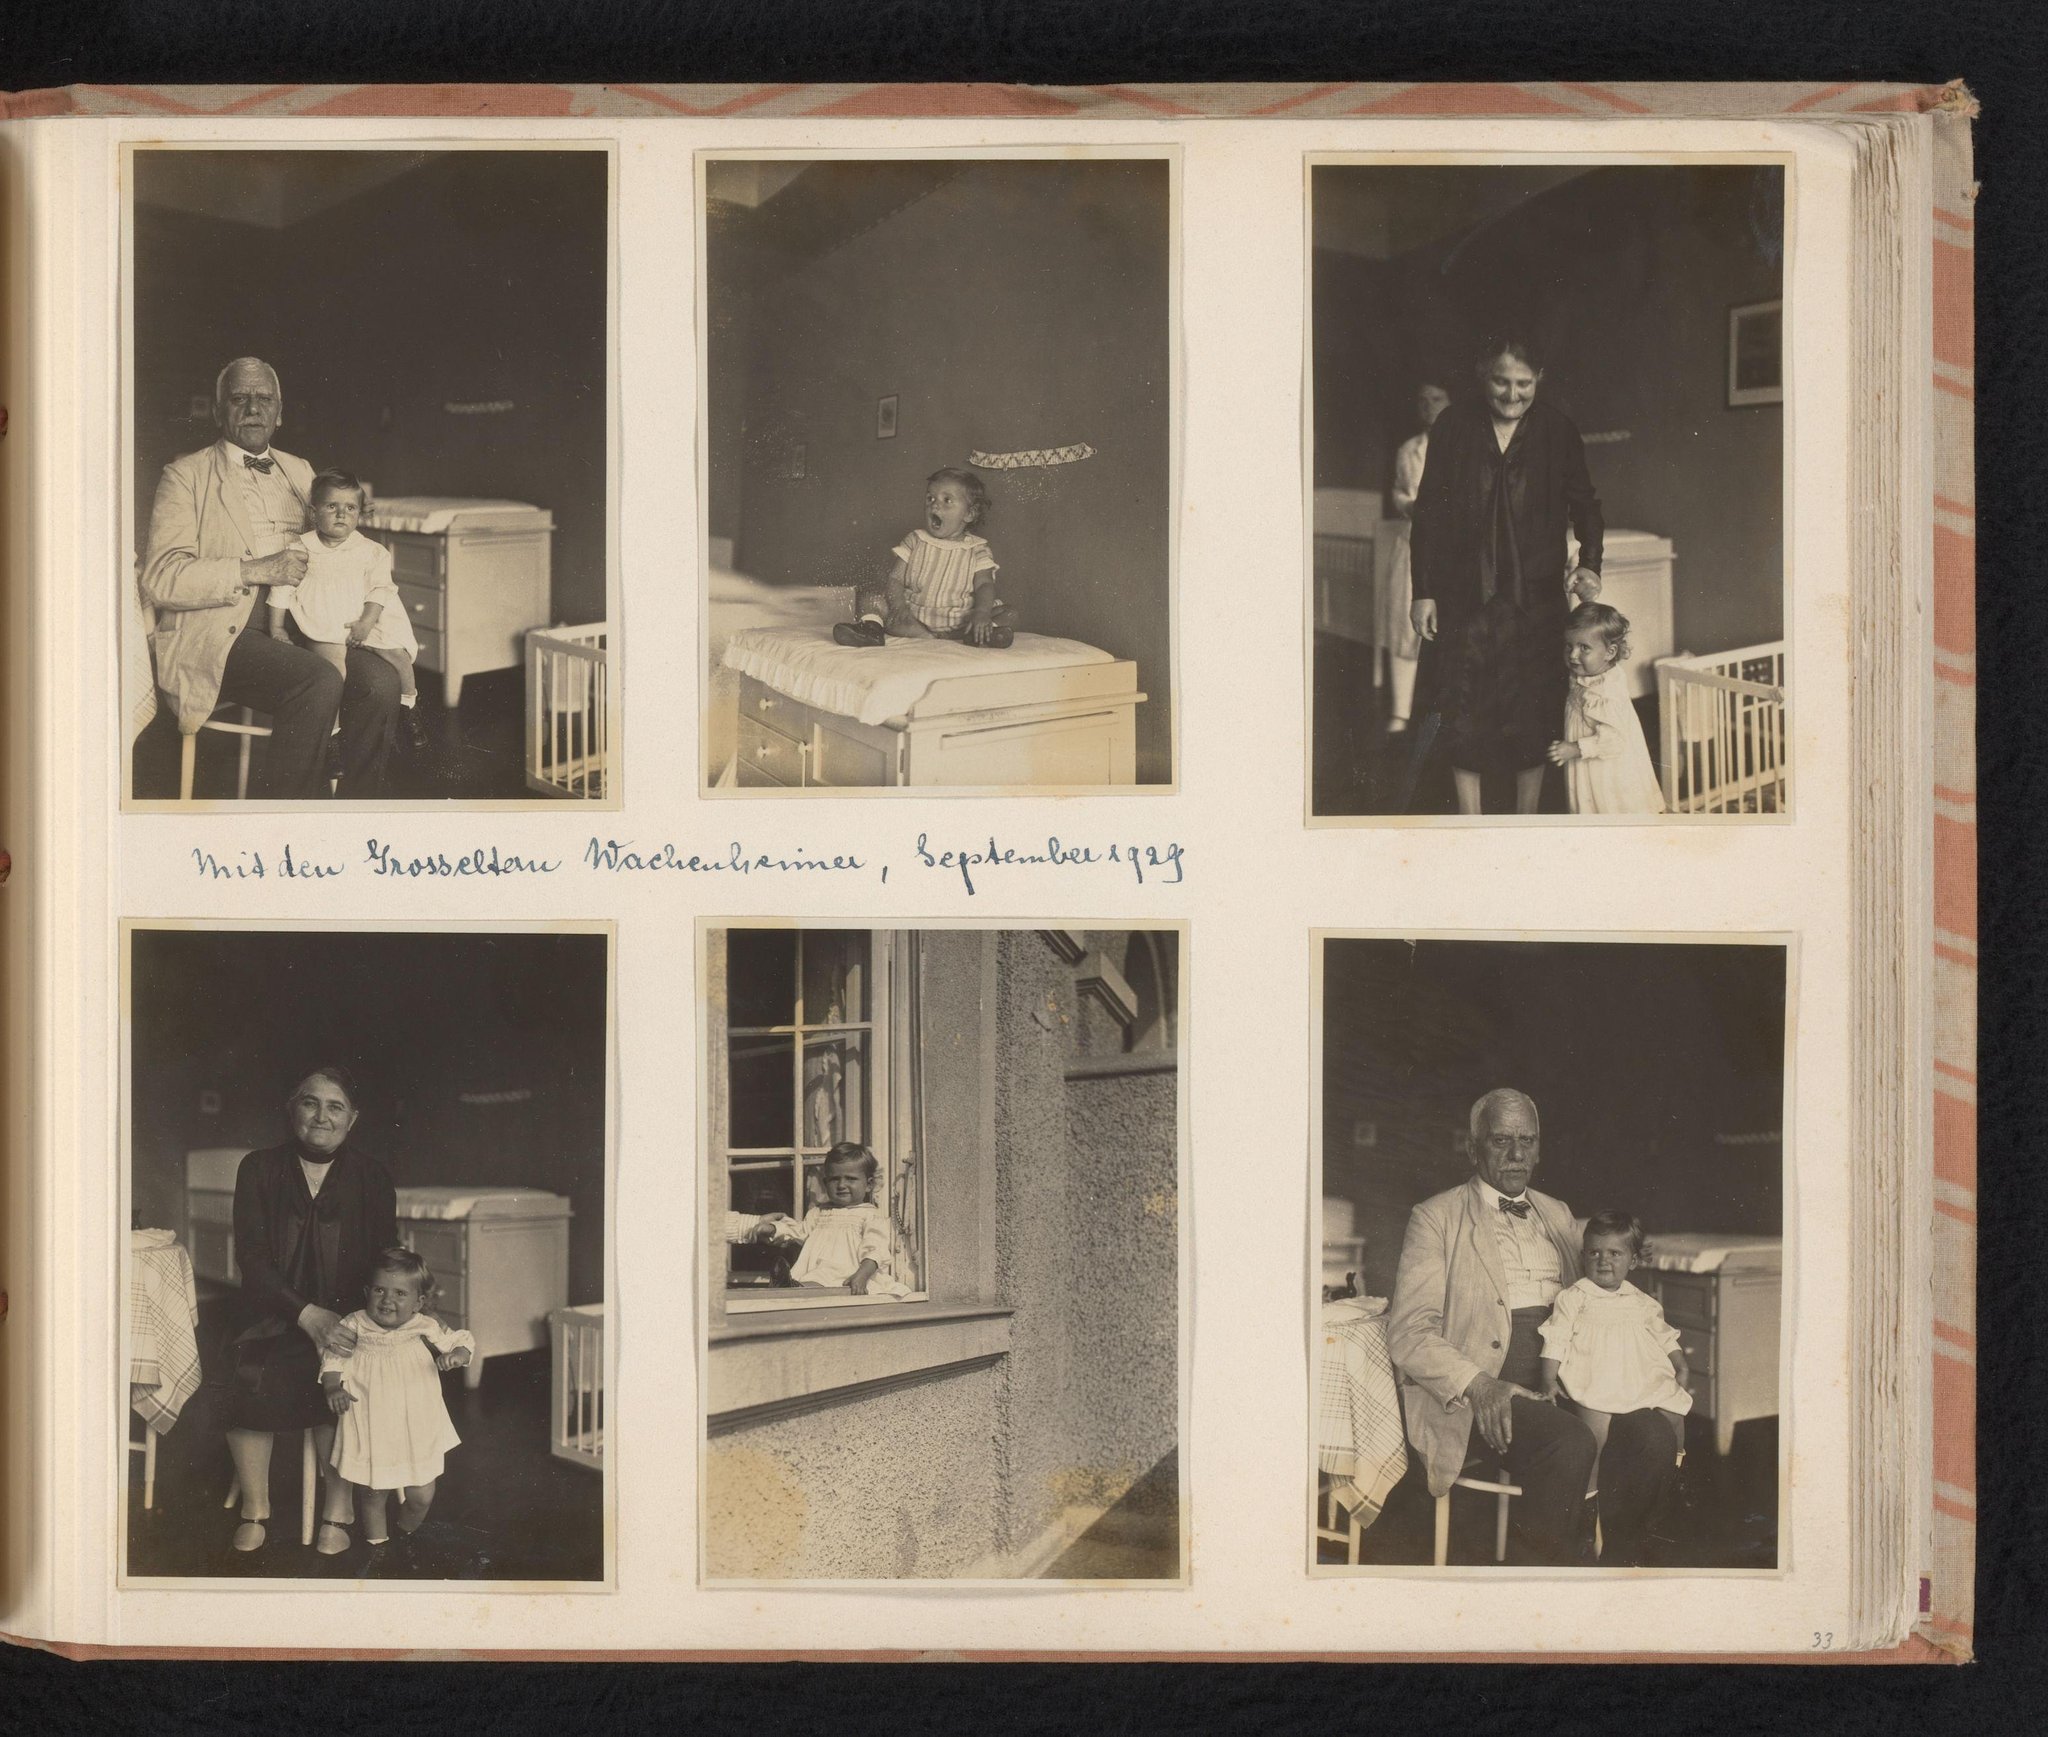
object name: album leaf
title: Isabel Wachenheimer met haar grootouders Meir Wachenheimer en Mathilde Wachenheimer-Wertheimer in de kamer van Isabel, München, september 1929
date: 1909-1929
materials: paper, photographic support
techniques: gelatin silver print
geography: munich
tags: leiden, isabel wachenheimer-elon, family life at home, grandparent(s) with grandchild(ren) (family group), infant, baby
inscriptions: inscription: ‘Mit den Grosseltern Wachenheimer, September 1929’